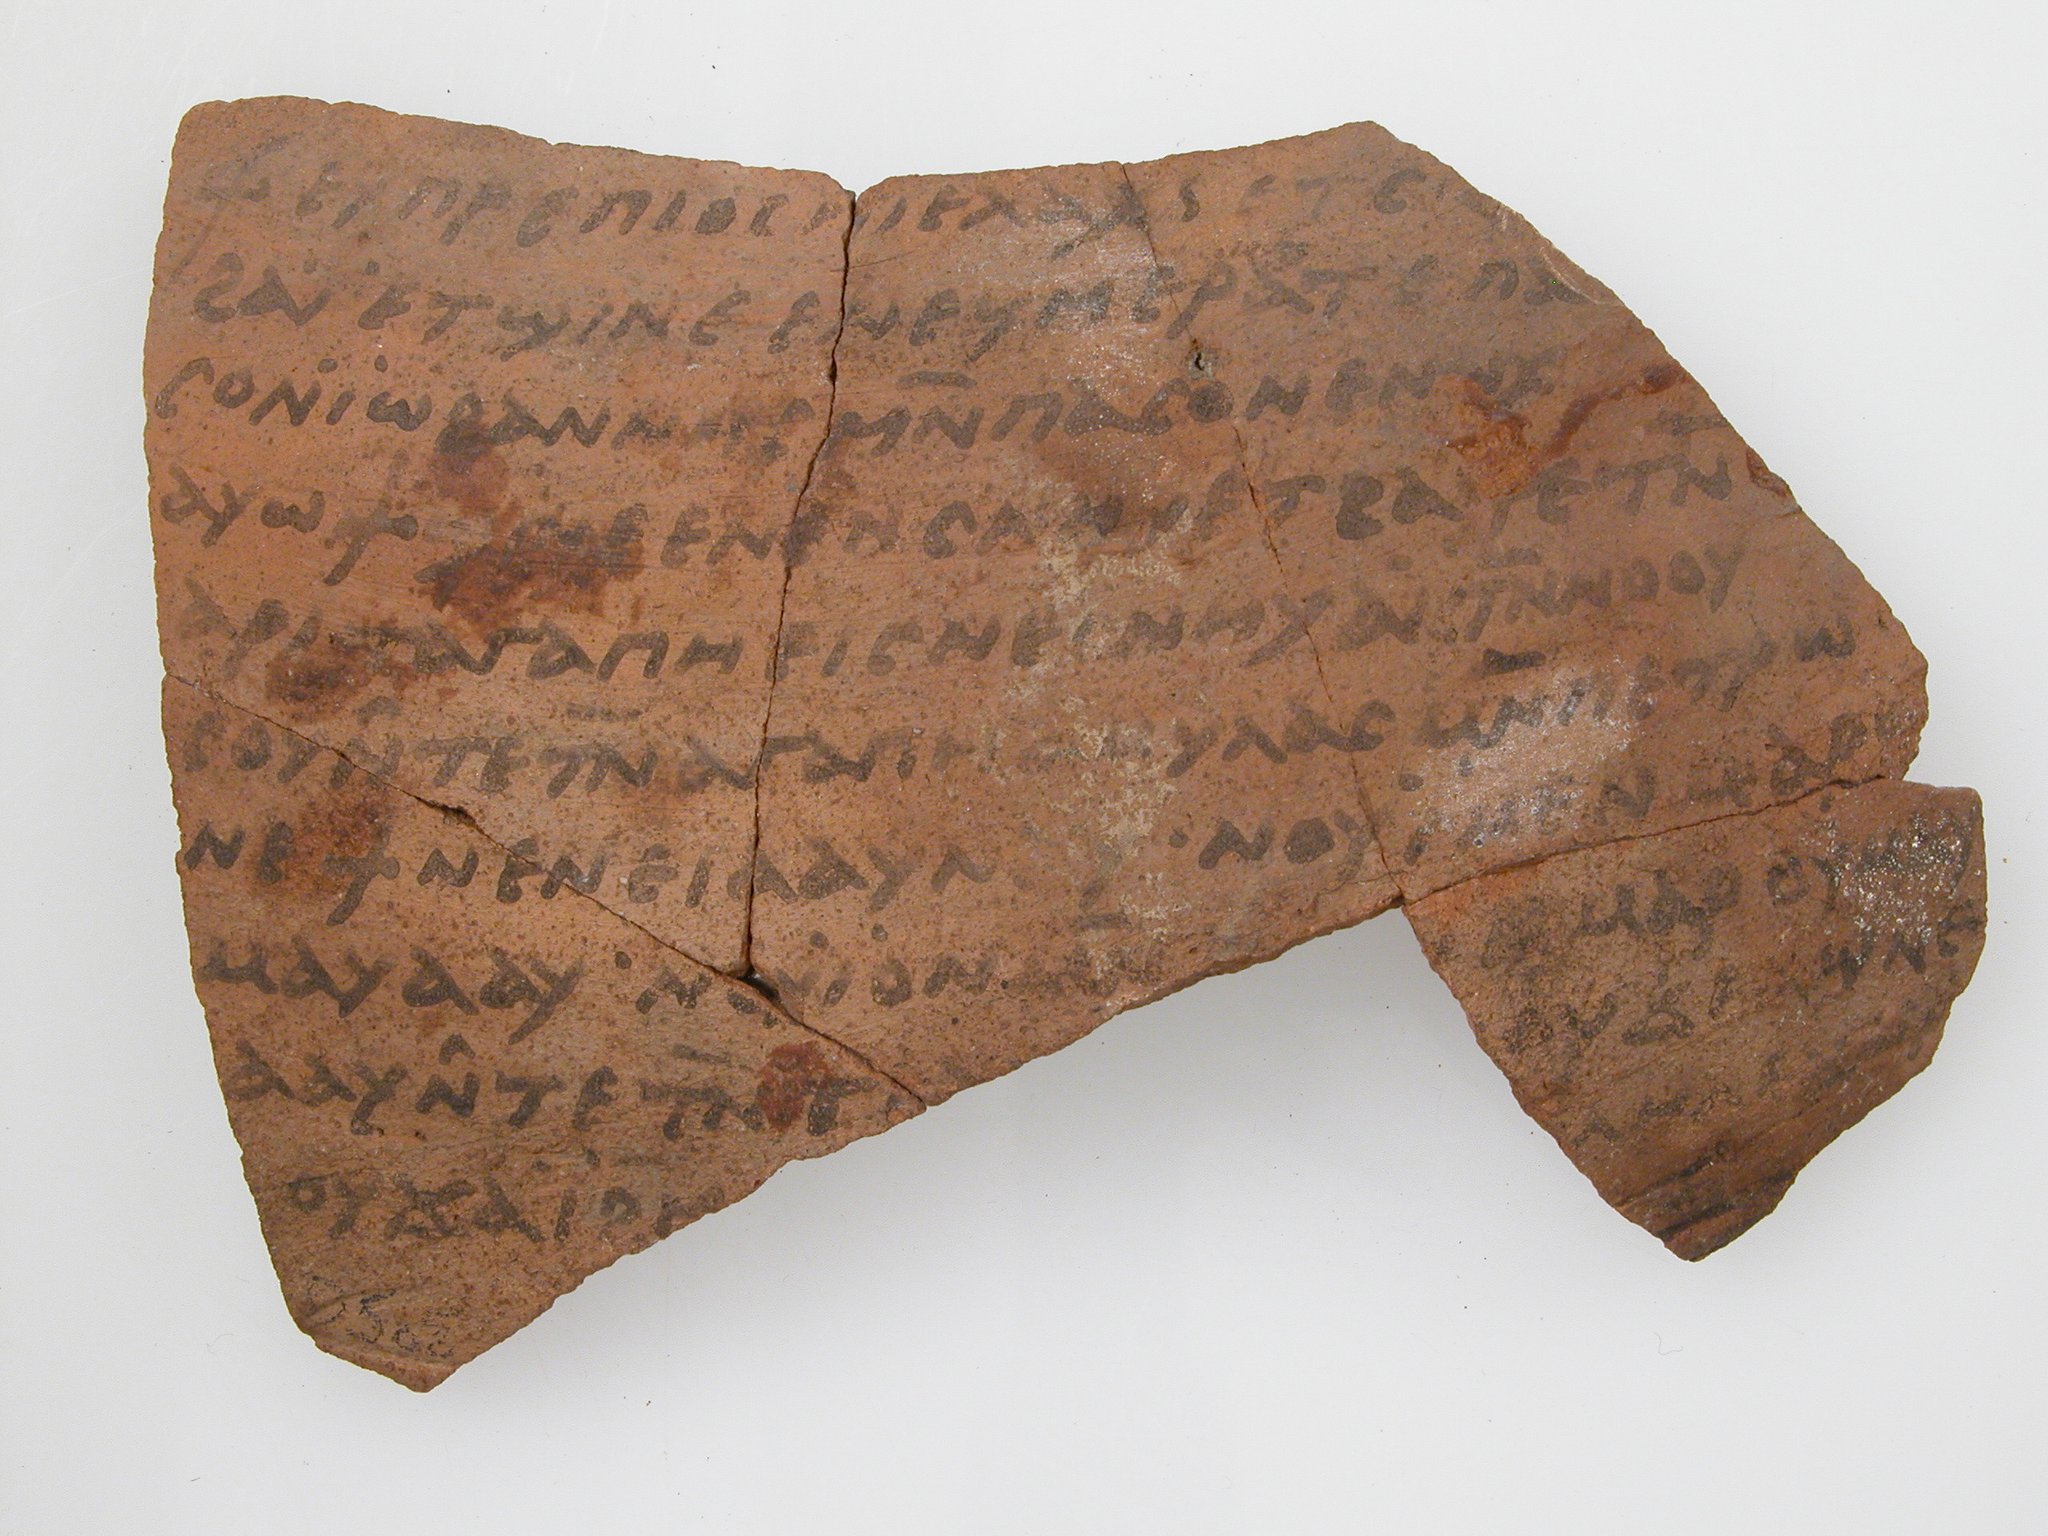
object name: ostrakon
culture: coptic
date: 580-640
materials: ink, pottery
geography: egypt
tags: coptic